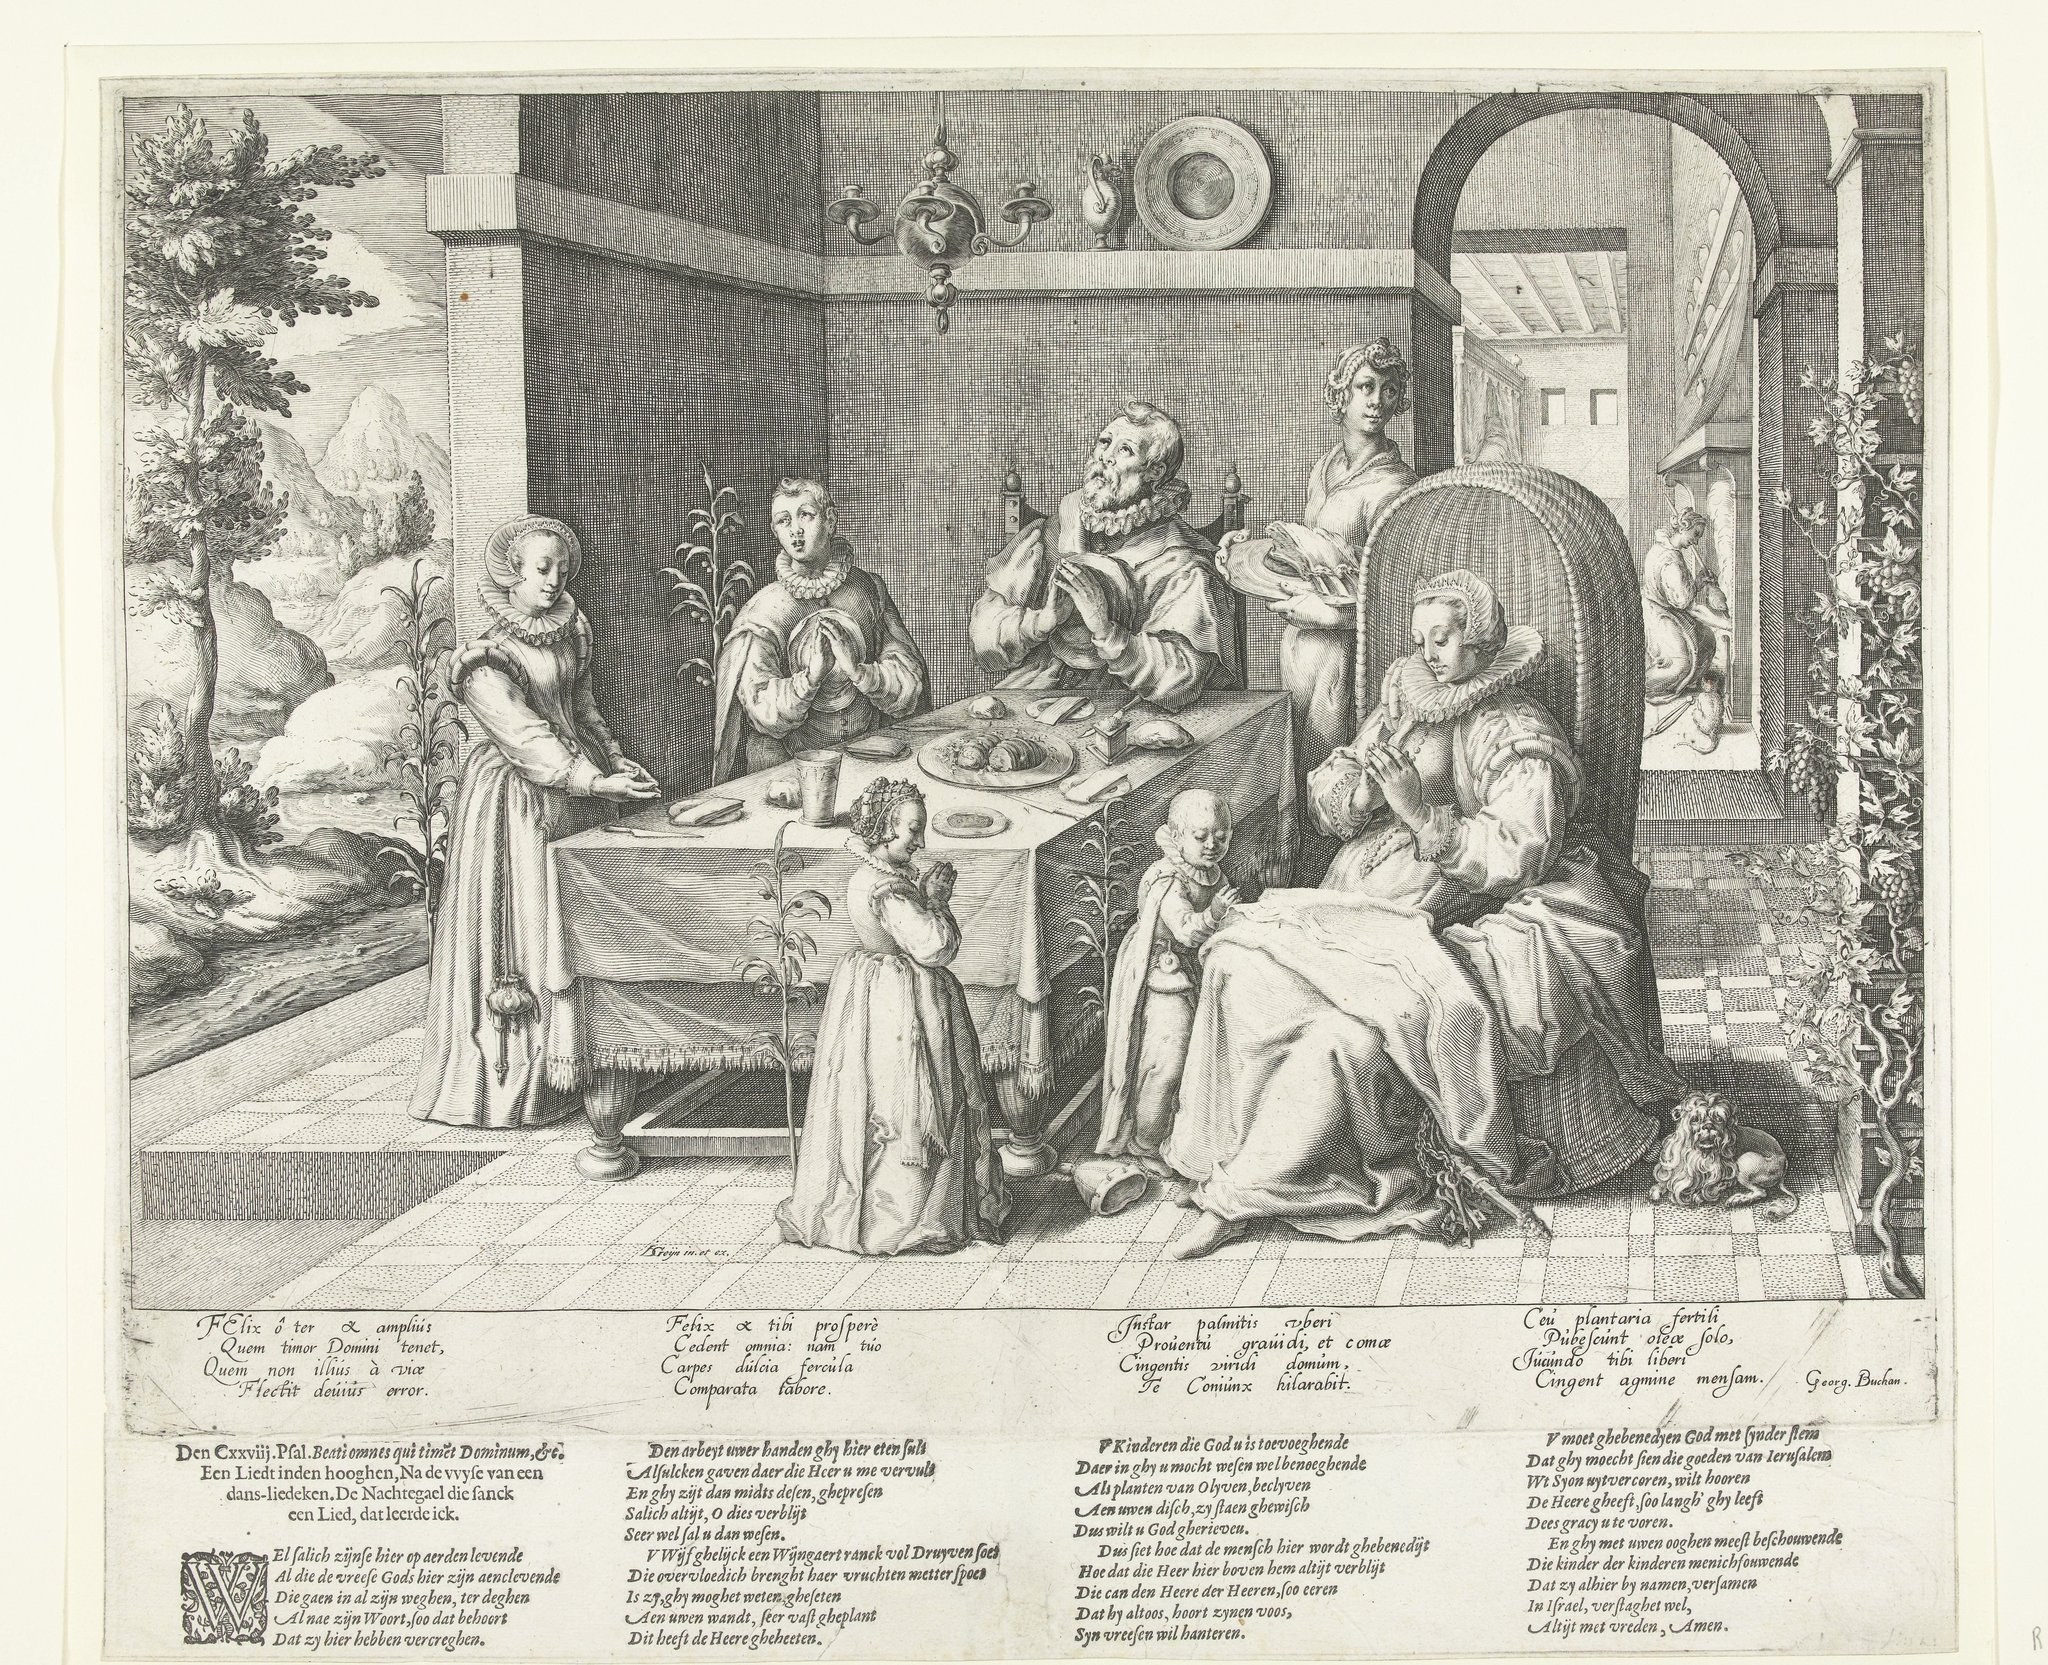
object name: print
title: Het gebed voor de maaltijd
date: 1593-1597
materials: paper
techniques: engraving, letterpress printing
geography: netherlands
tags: (family) meal (+ serving, servants at table, meal), laid table: table-ware, table-decoration, etc. (+ serving, servants at table, meal), (private) prayer; 'oratione', 'preghiere', 'preghiere a dio' (ripa), prayer at table, saying grace, (family) meal, kitchen-personnel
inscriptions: collector's mark: Lugt 240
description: In een vertrek bidden een echtpaar en hun vier kinderen voor de maaltijd die op tafel klaarstaat. Achter de rug van elk van de kinderen groeit een plantje. Een dienstmeisje serveert een stuk vlees op een bord. Op de achtergrond is een dienstmeisje te zien bij een haardvuur. Onder de voorstelling een Latijns gedicht in vier kwatrijnen. Buiten de plaatrand maar op hetzelfde blad helemaal onderaan tevens een gedrukte Nederlandse psalmtekst in 4 kolommen.